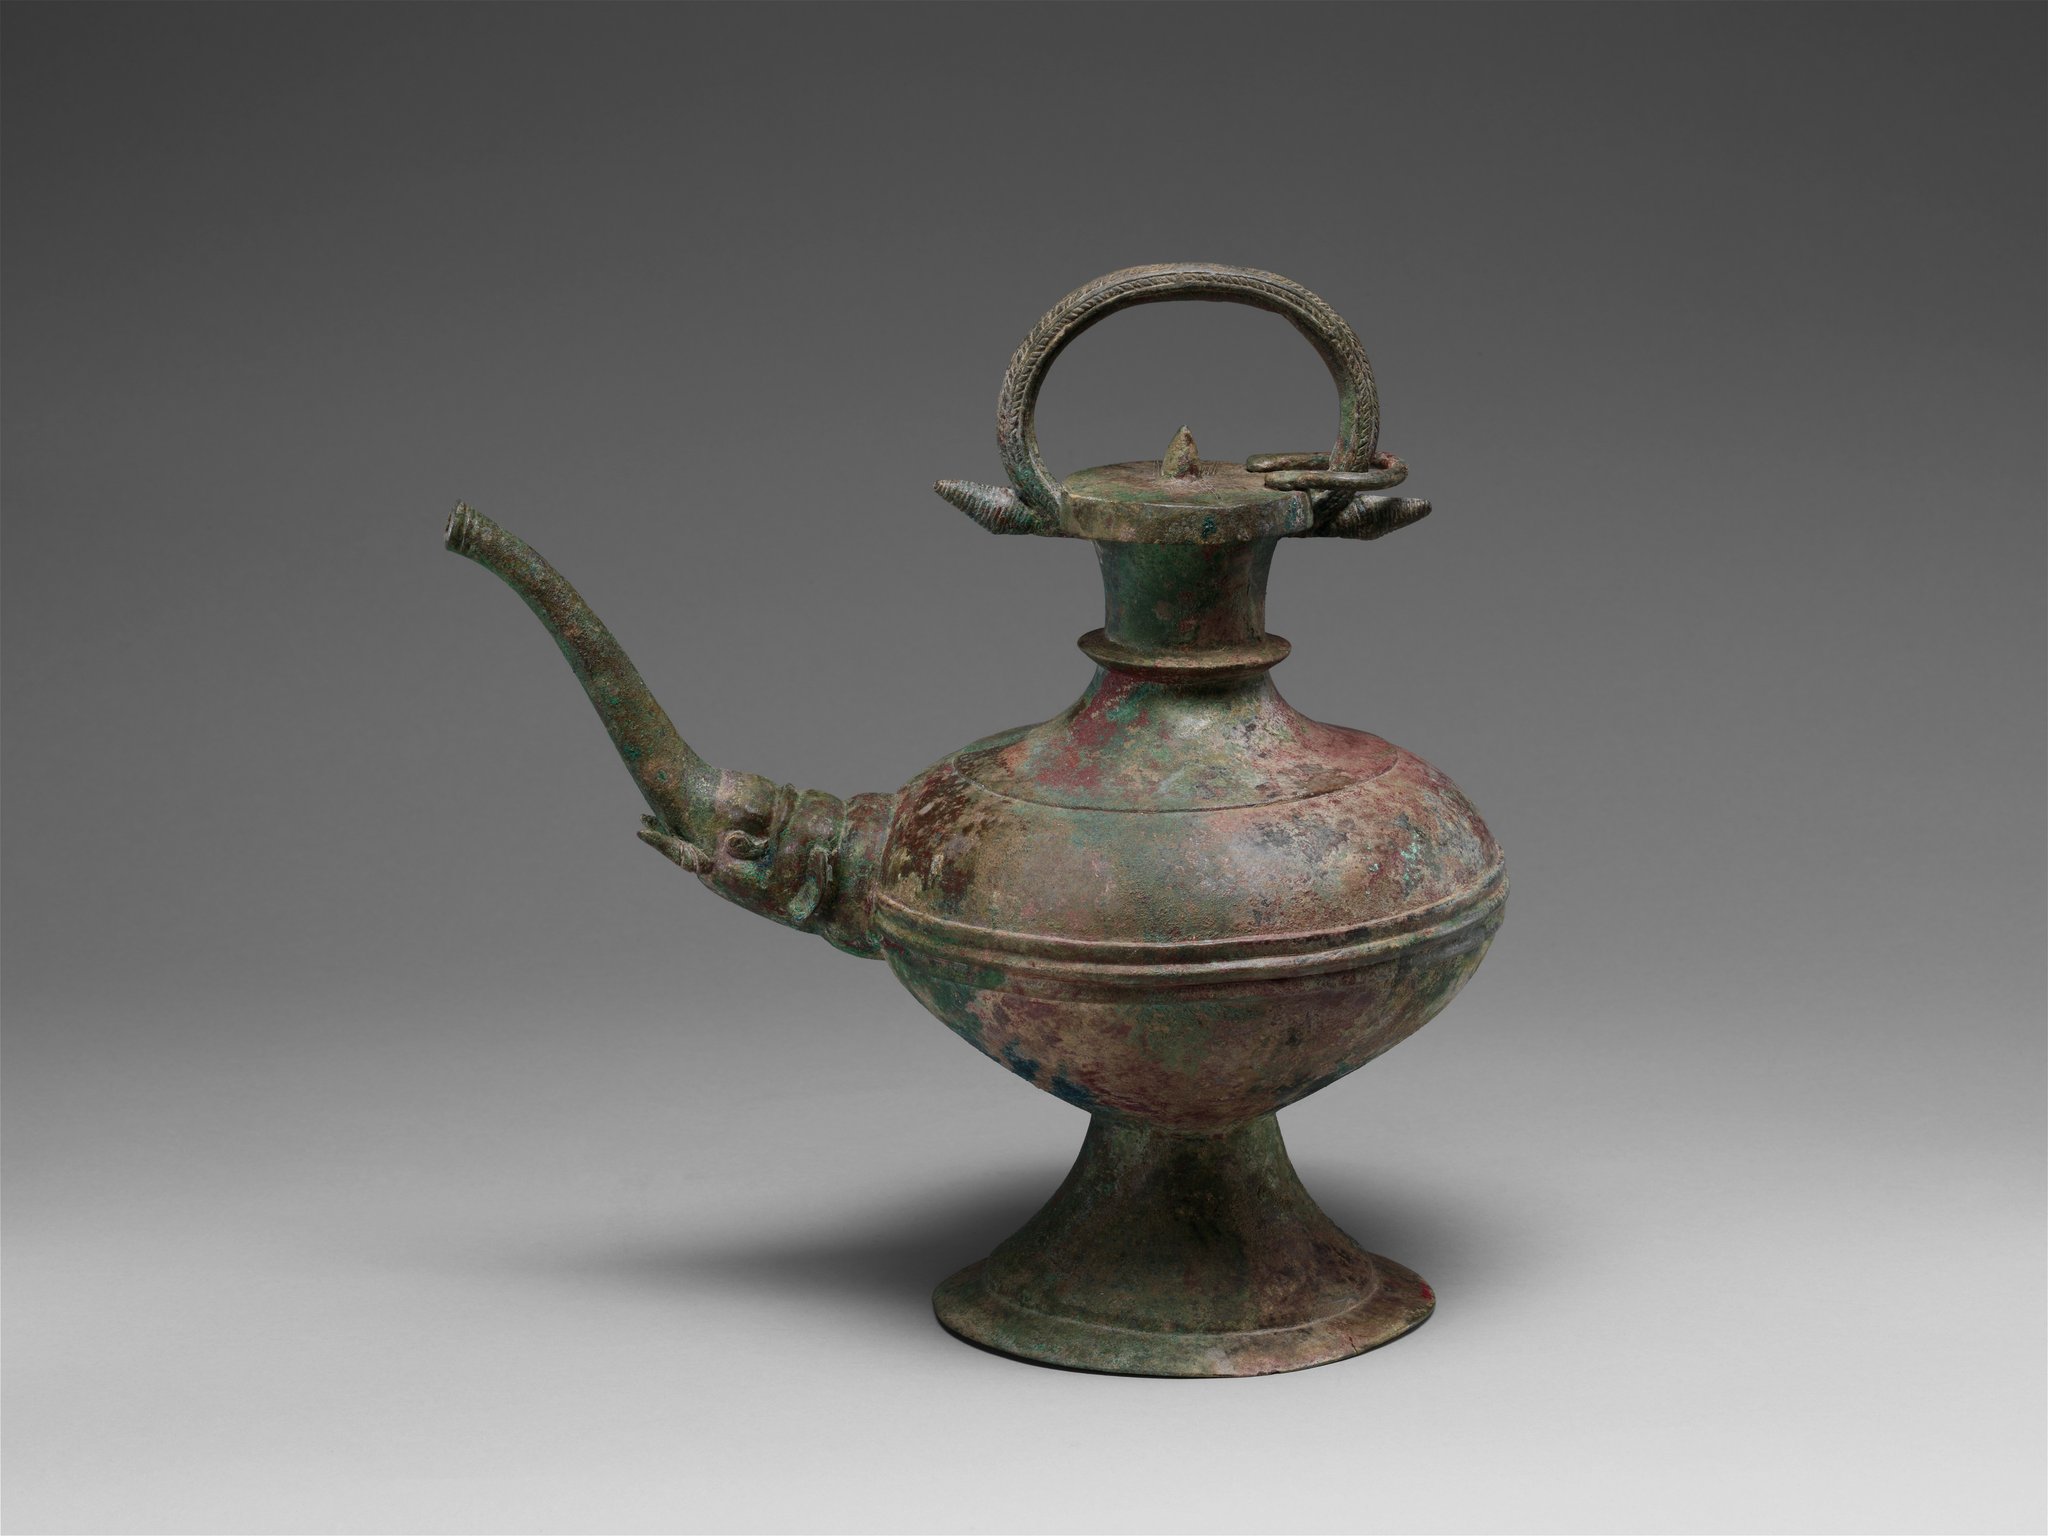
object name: ewer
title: Ewer with Elephant-Headed Spout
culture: vietnamese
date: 167-300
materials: bronze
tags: elephants